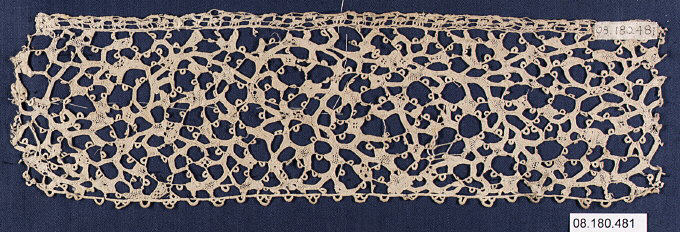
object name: fragment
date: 1601-1700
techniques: lace